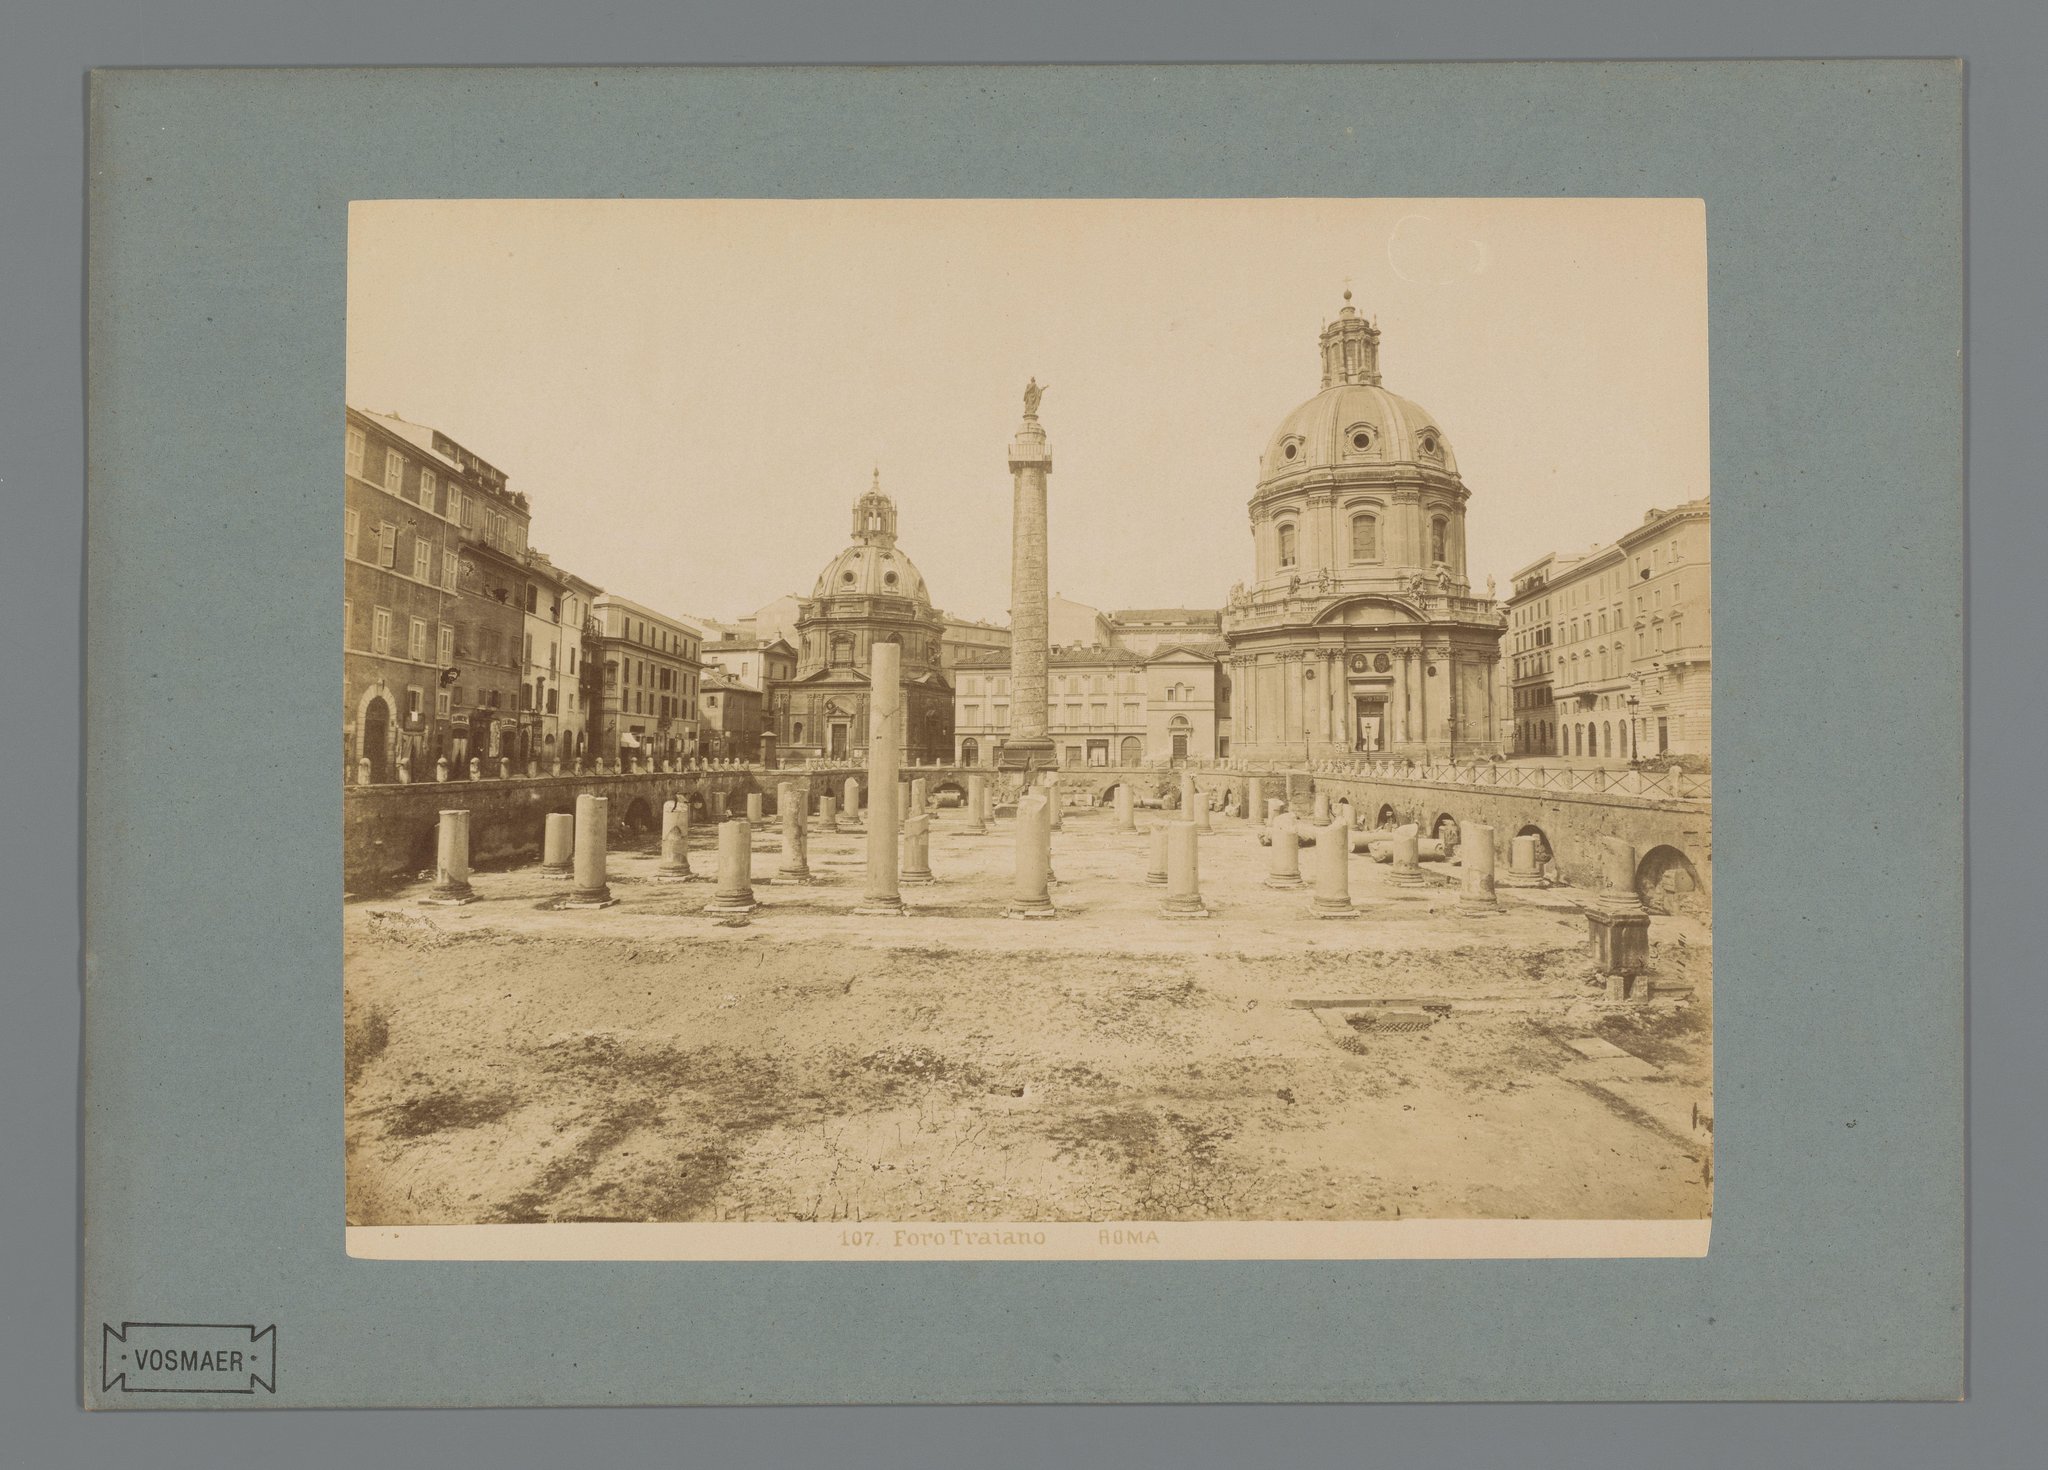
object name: photograph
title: Foro Traiano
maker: Anonymous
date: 1851-1890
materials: cardboard, paper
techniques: albumen print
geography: rome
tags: ruin of a building ~ architecture, village square, place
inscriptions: collector's mark: ‘VOSMAER’, number: ‘107.’